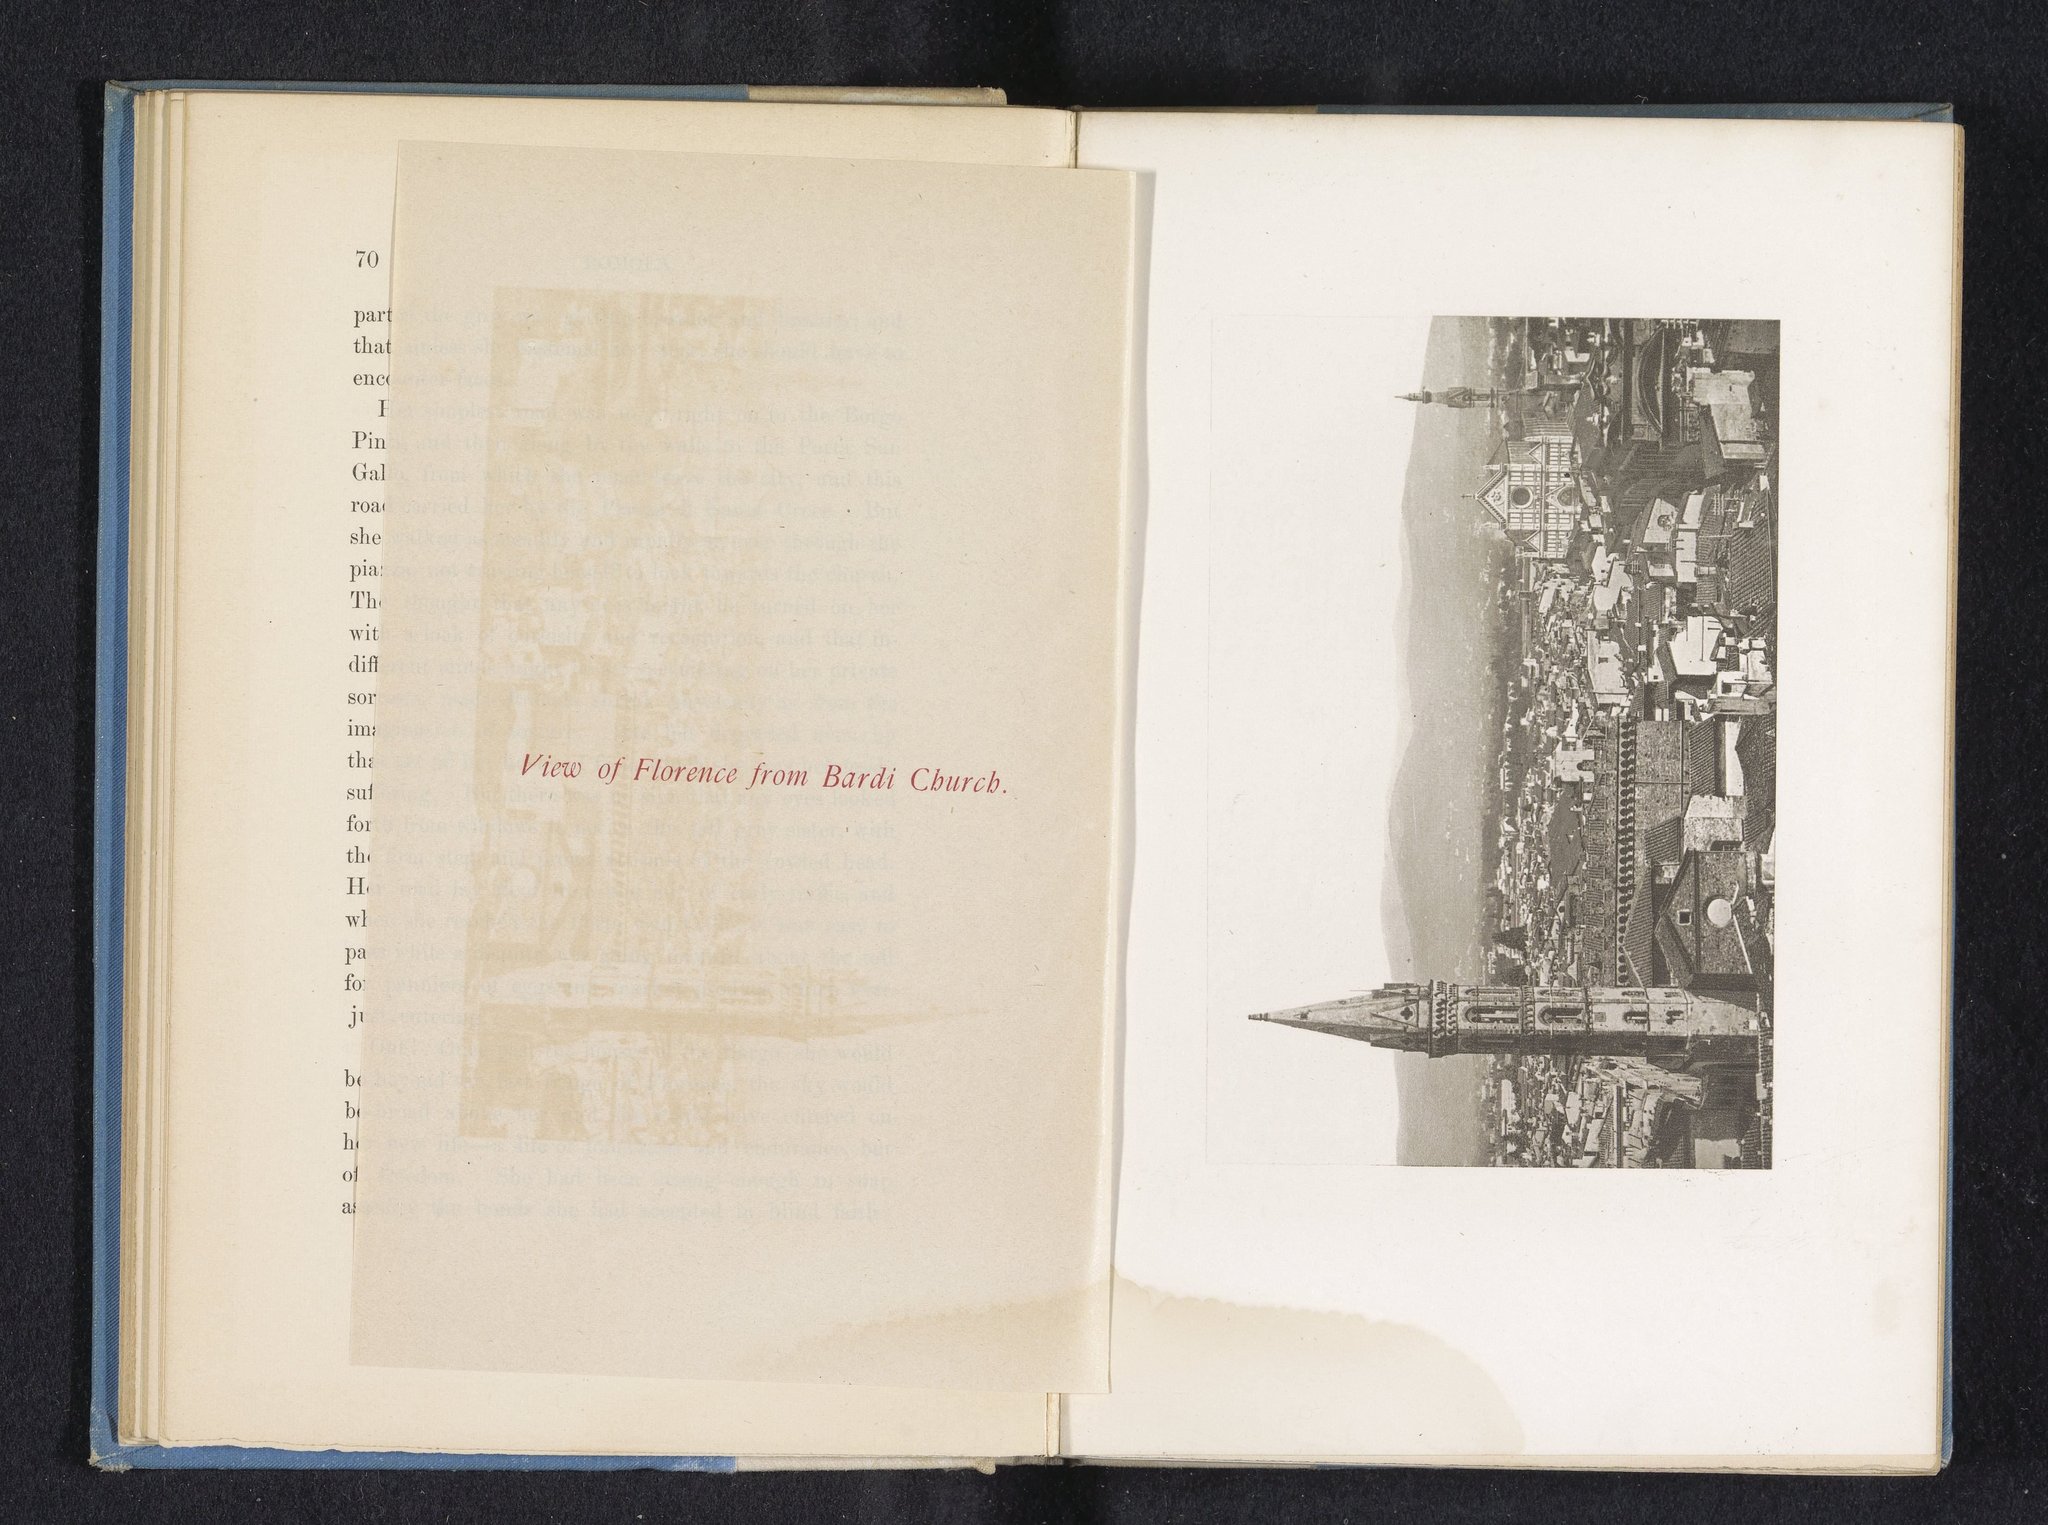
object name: photomechanical print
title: Gezicht op Florence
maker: Anonymous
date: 1880-1890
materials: paper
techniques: photoaquatint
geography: boston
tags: city-view in general; 'veduta'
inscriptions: title: ‘View of Florence from Bardi Church.’